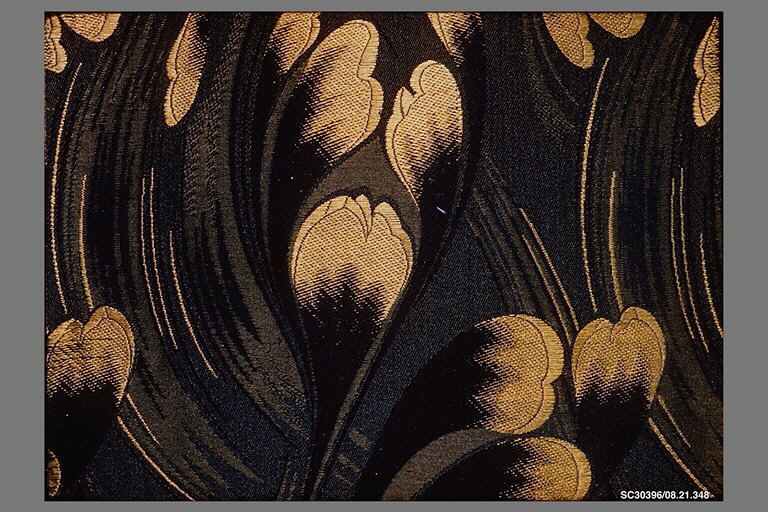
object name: textile sample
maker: Anonymous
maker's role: designer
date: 1900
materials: silk